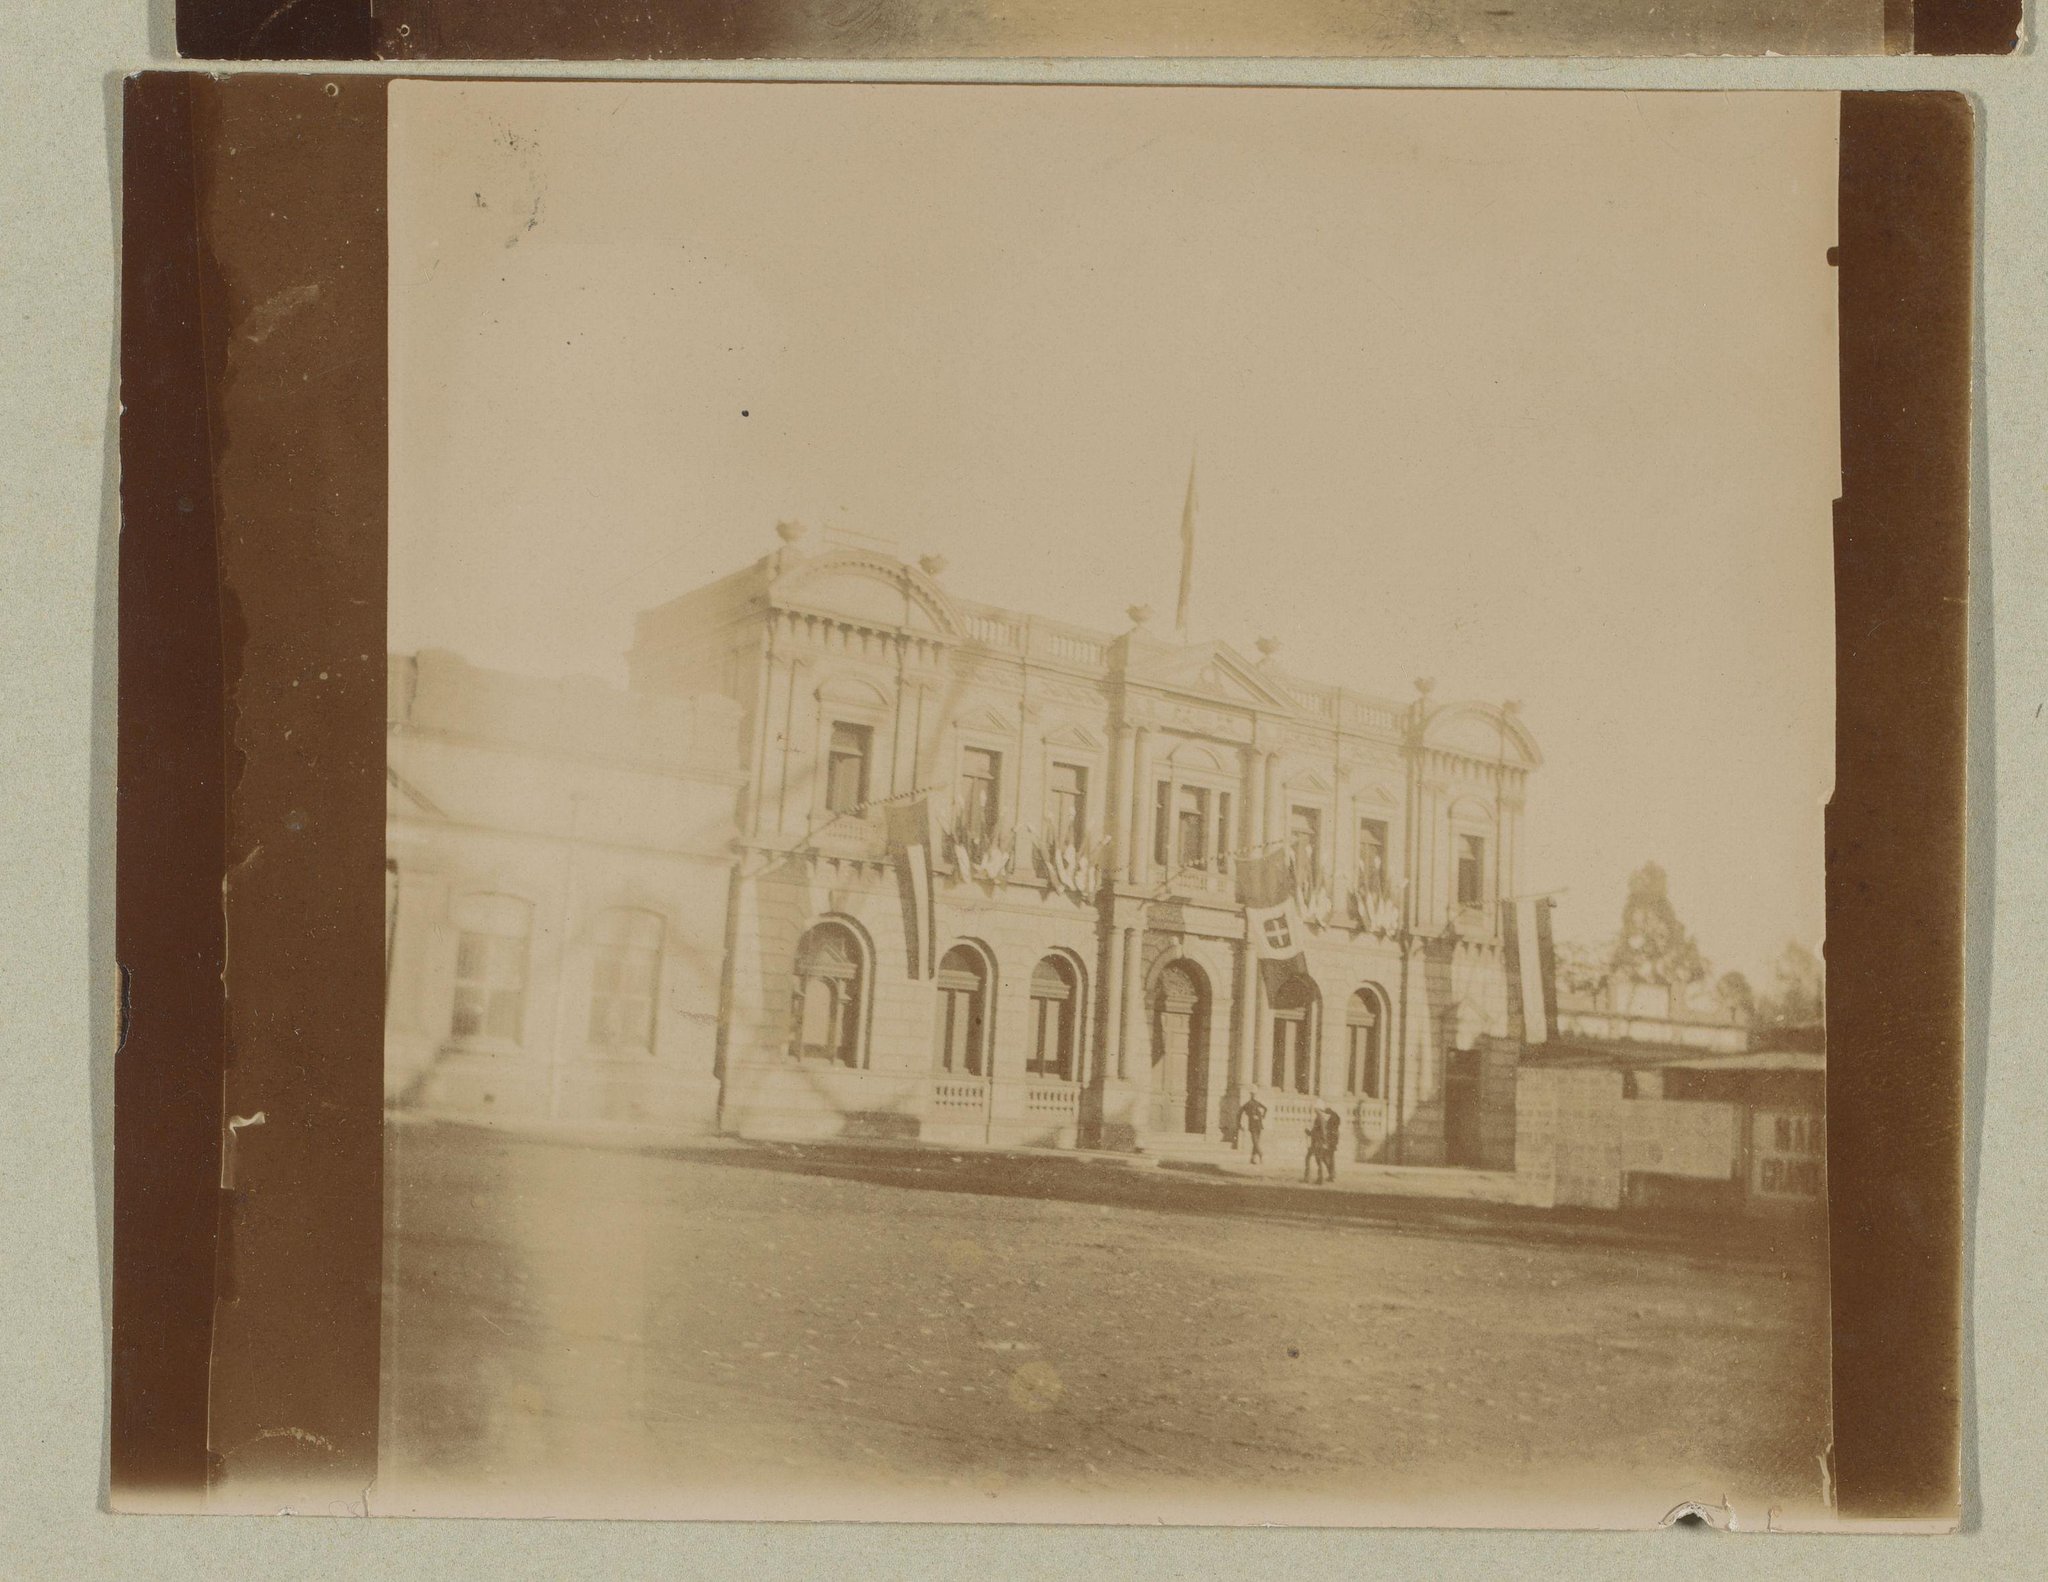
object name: photograph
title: Exterieur van een gebouw, waarschijnlijk aan het Kerkplein in Pretoria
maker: Anonymous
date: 1898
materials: paper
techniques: gelatin silver print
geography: pretoria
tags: exterior ~ representation of a building